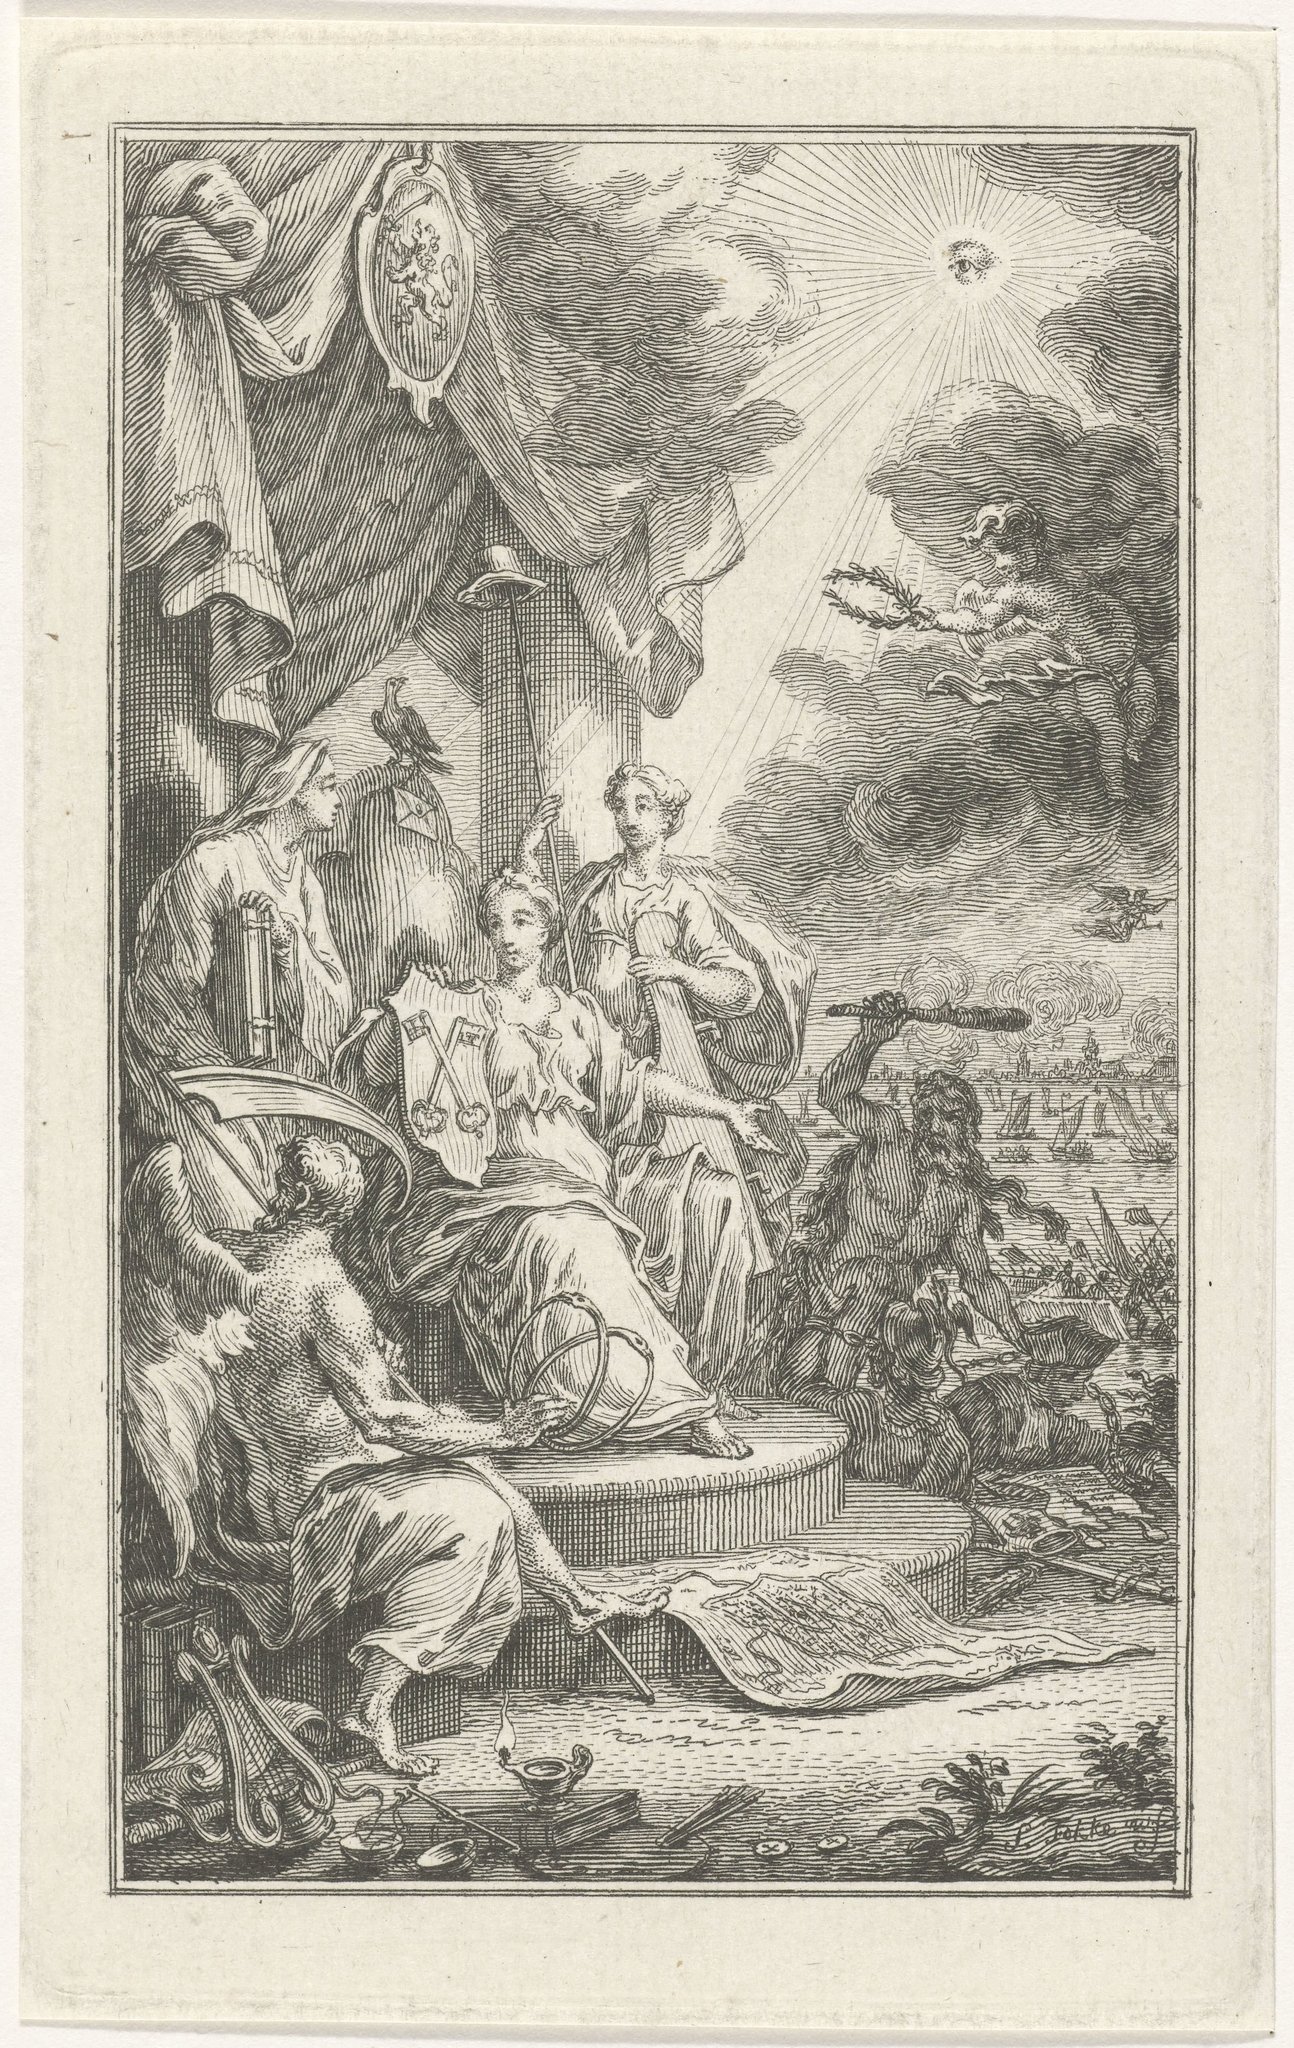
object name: print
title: Tronende vrouw met het wapenschild van Leiden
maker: simon fokke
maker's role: draughtsman, print maker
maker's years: 1712-1784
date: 1722-1784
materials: paper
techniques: etching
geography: amsterdam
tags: personification of a city, town-patron(ess), cities represented allegorically or symbolically, freedom, liberty; 'libertà' (ripa), father time, man with wings and scythe, leiden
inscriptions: collector's mark: Lugt 2228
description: Een tronende vrouw houdt het wapen van de stad Leiden in haar hand en wordt beschenen door stralen die afkomstig zijn van het Alziend Oog. Ze wordt omringd door personificaties van de Vrijheid en Religie. Links voor de troon zit Vader Tijd met het eeuwigheidssymbool in zijn handen; slangen die zich in hun eigen staart bijten. Rechts worden op de achtergrond geketende figuren met een knots uitgedreven.